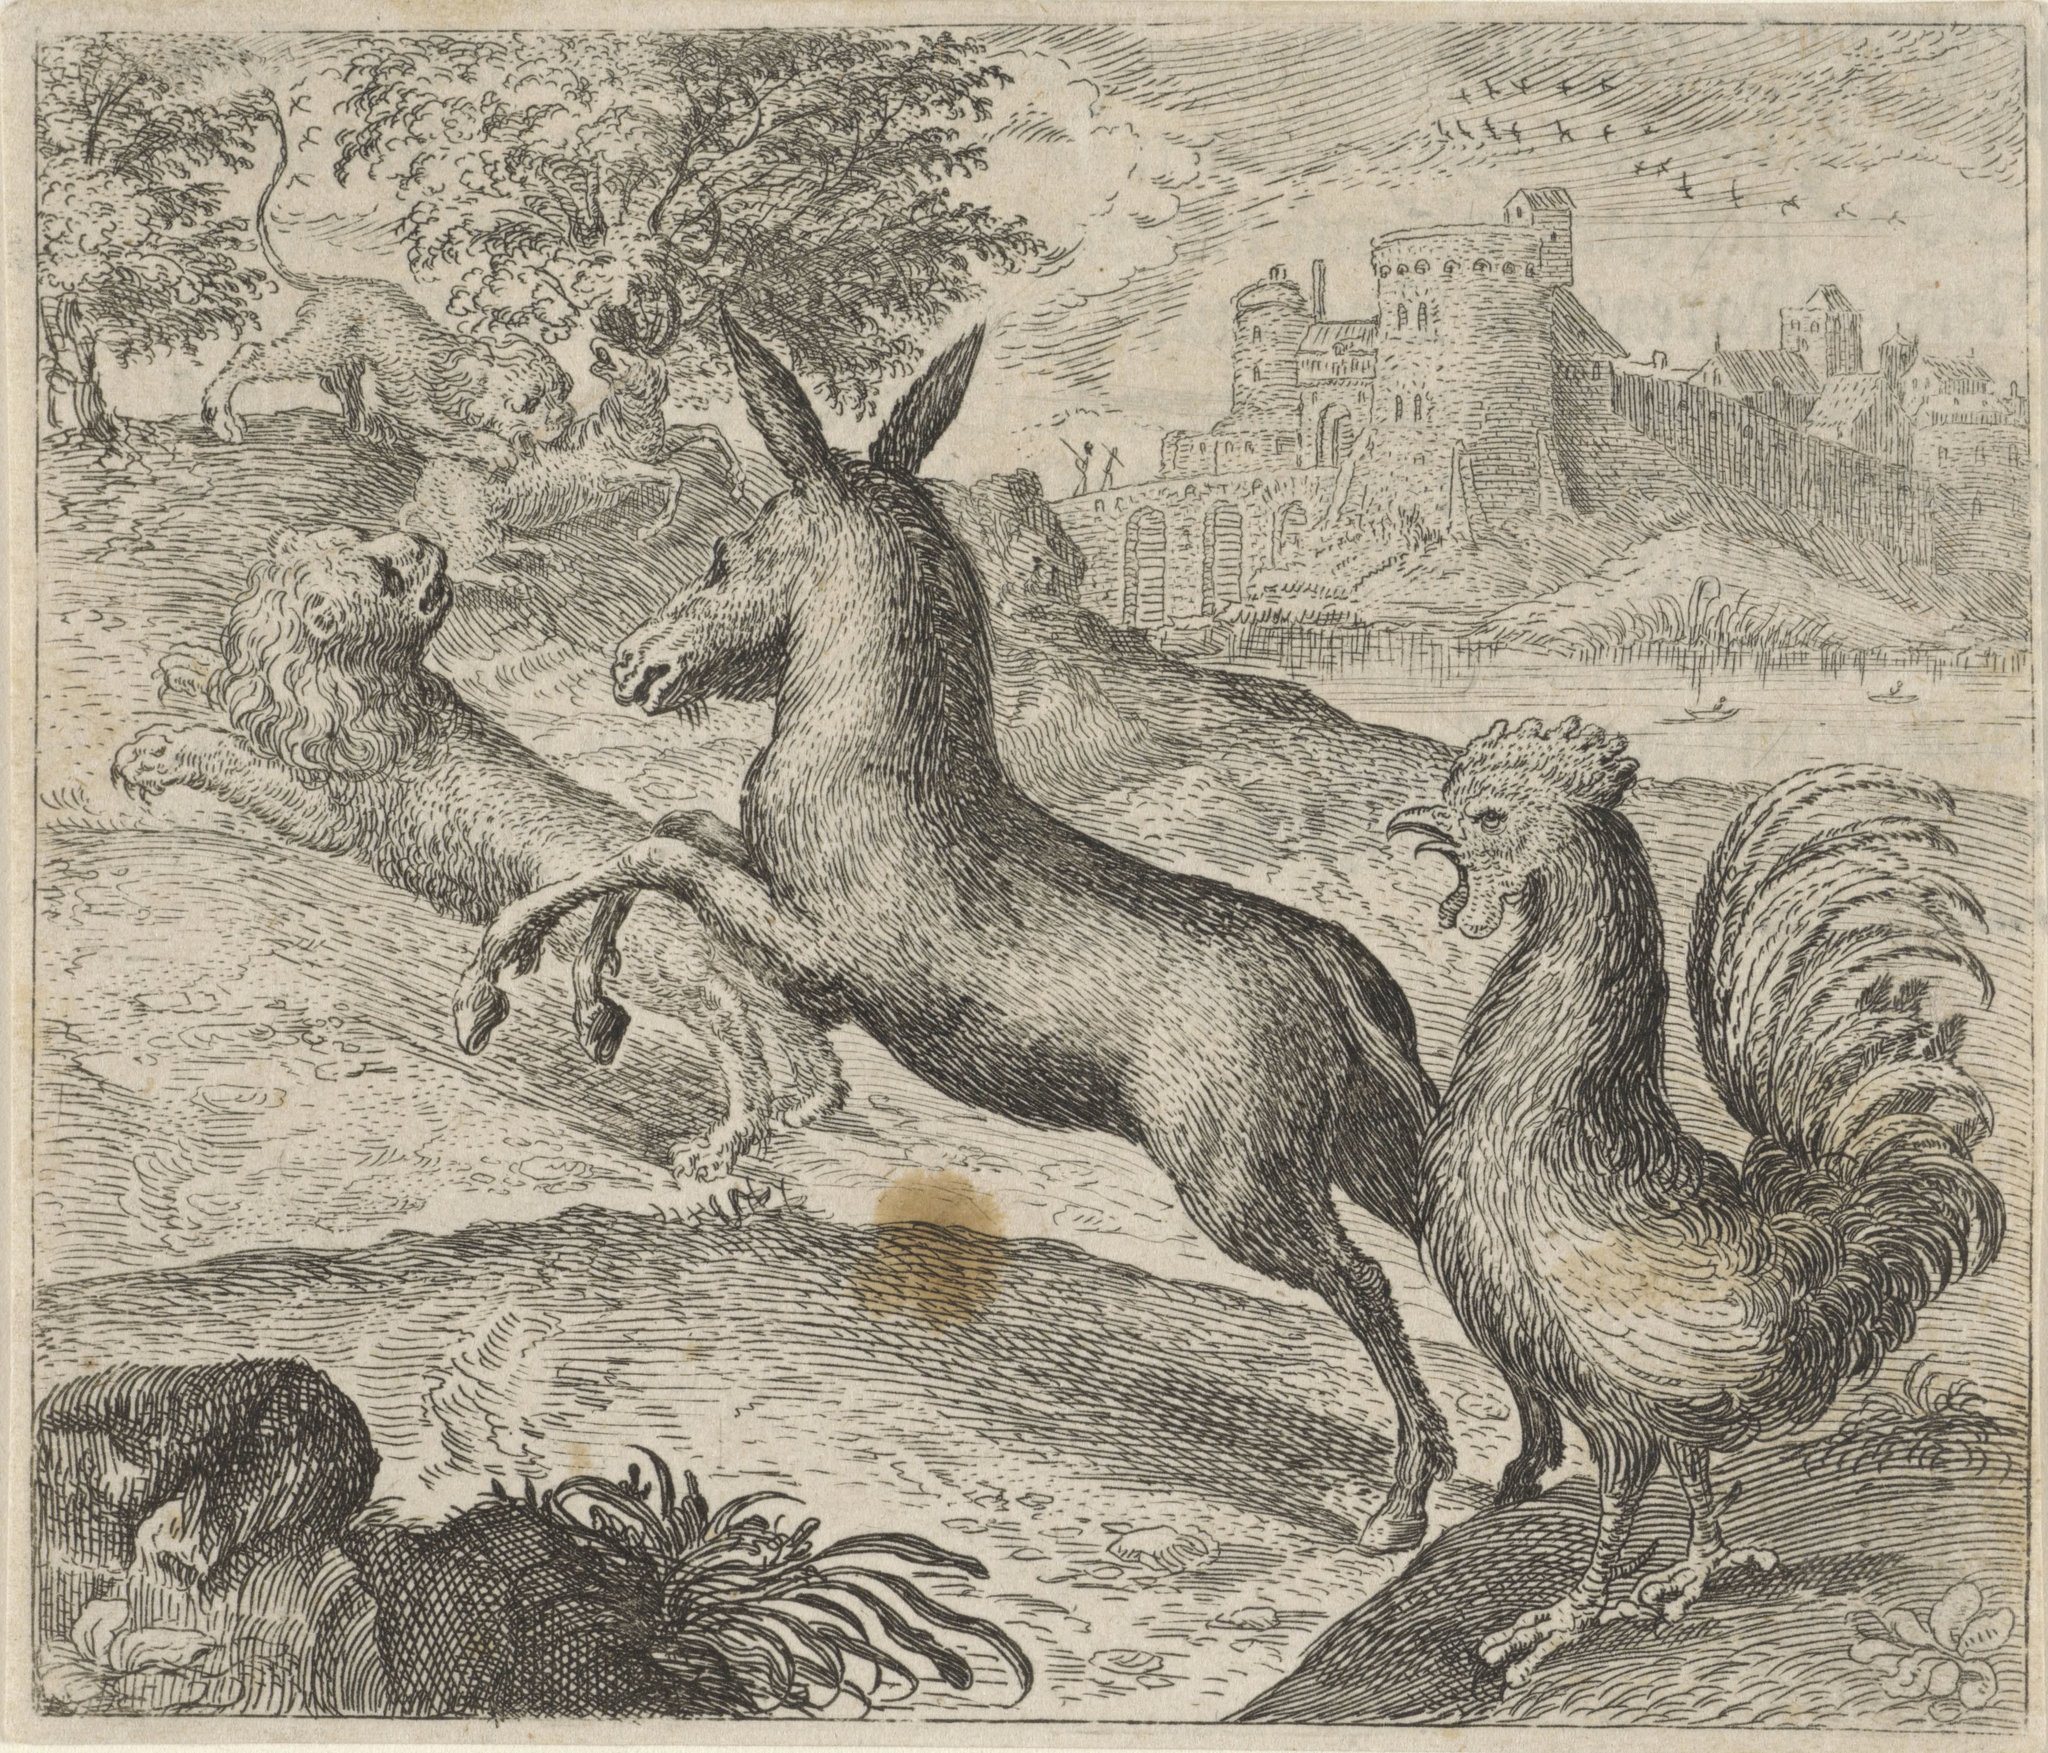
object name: print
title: Fabel van de leeuw, ezel en haan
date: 1608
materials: paper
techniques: engraving, etching, letterpress printing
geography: prague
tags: ass, donkey, fowl (cock, hen, chicken, etc.), fables, beasts of prey, predatory animals: lion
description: Een haan kraait en jaagt een leeuw op de vlucht. Een ezel zet de achtervolging in en wordt op de achtergrond door de leeuw verscheurd. De moraal van het verhaal leert dat je eerst moet nadenken voordat je handelt.